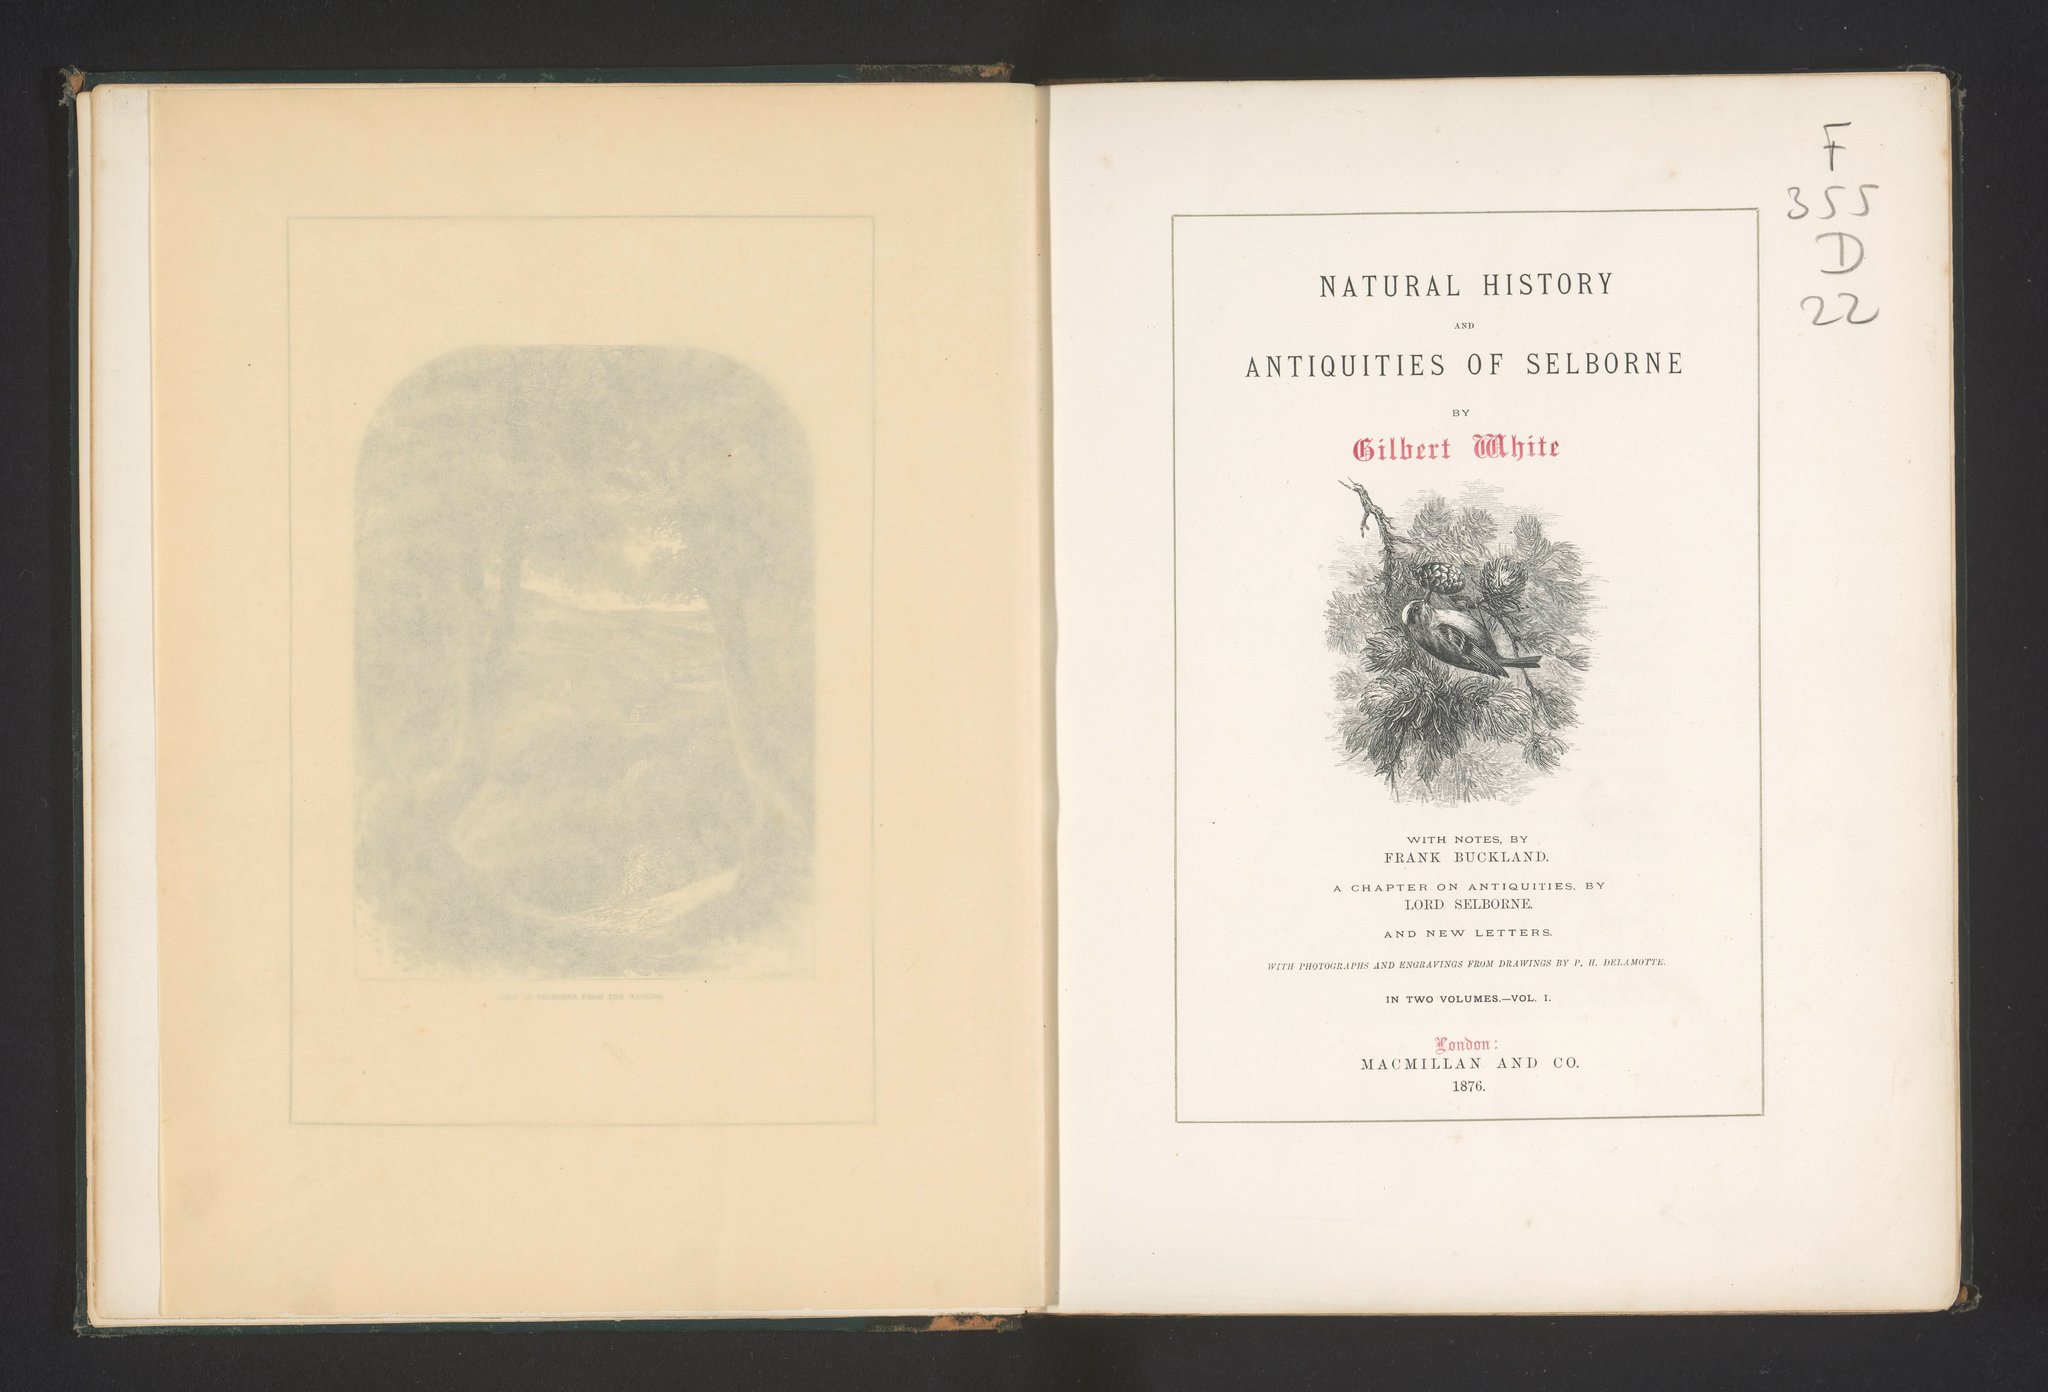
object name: book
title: Natural history and antiquities of Selborne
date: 1876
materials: cardboard, leather, linen, paper, photographic support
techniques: carbon print, decorated paper, engraving, printing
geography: london